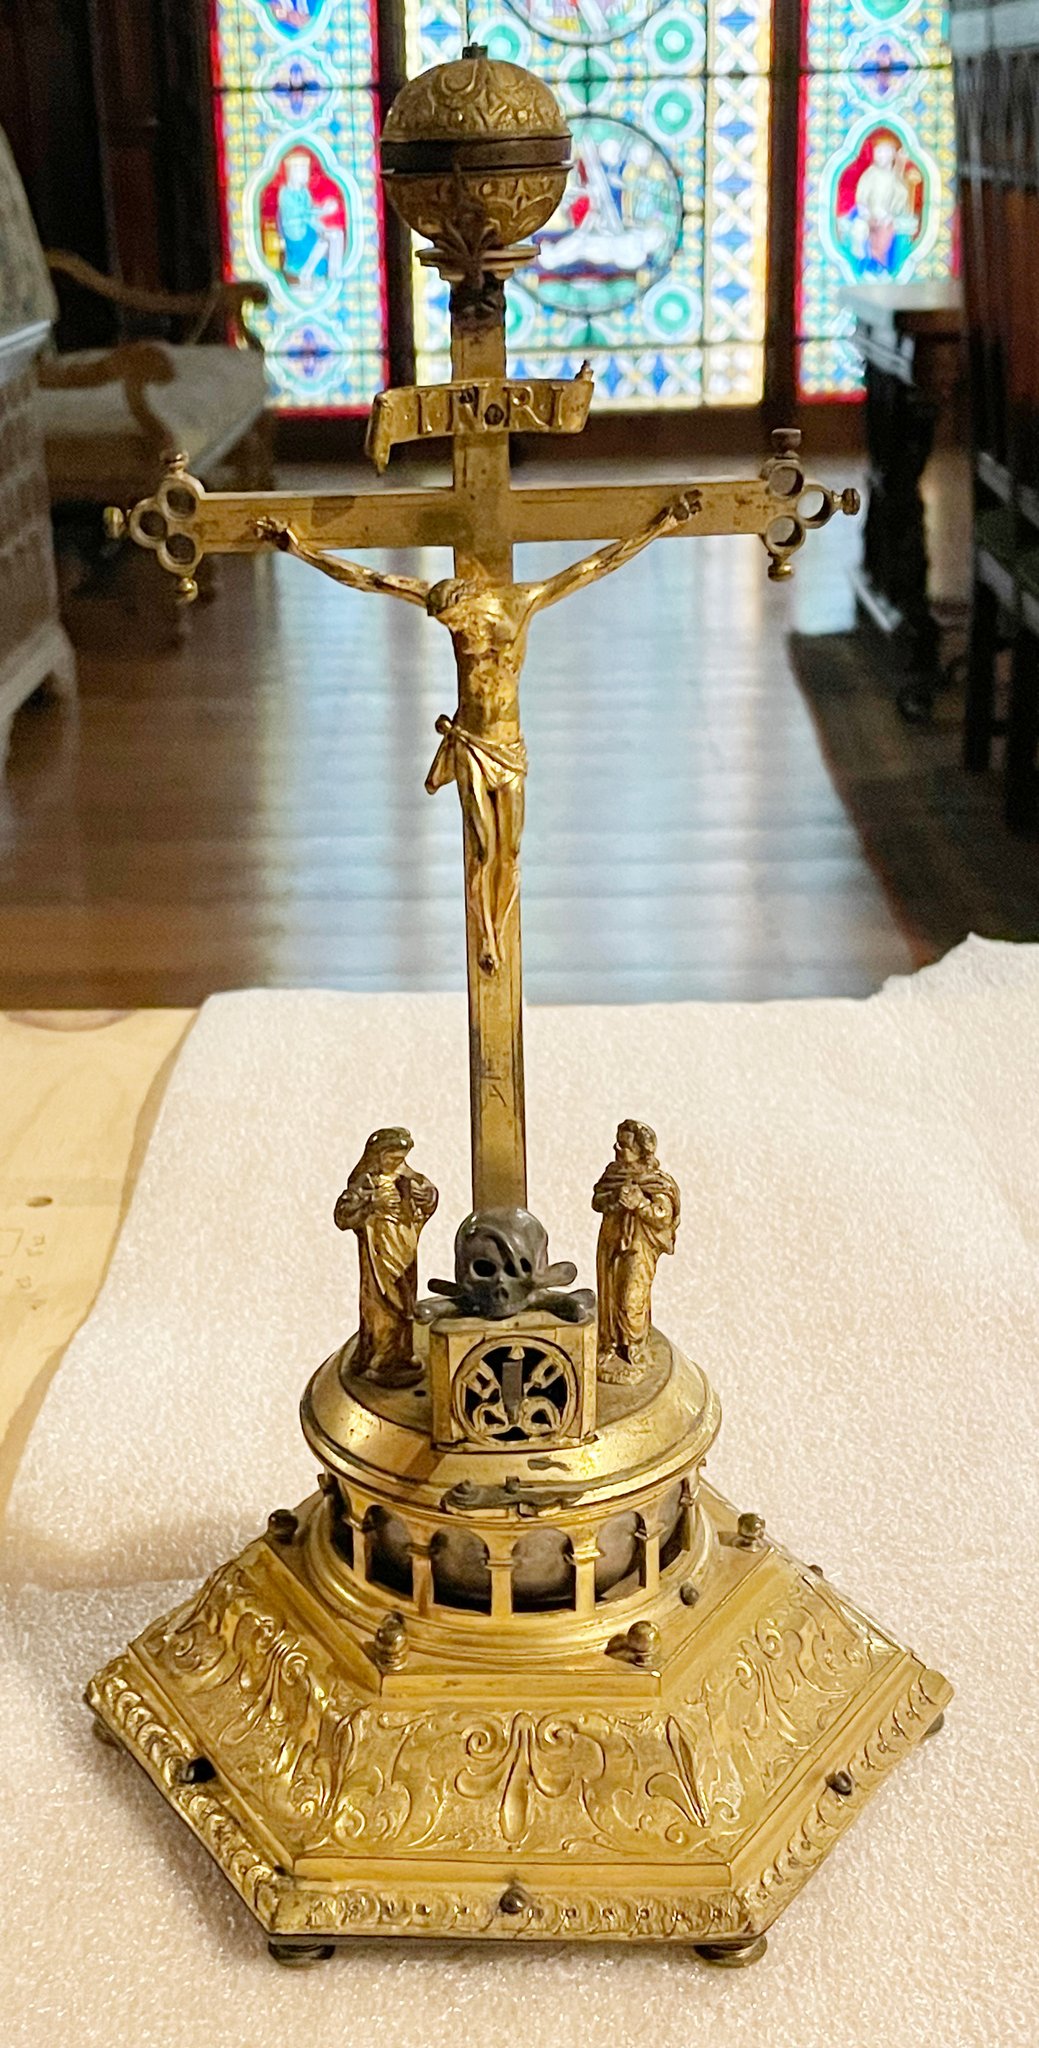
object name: clock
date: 1601-1633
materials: gilt copper